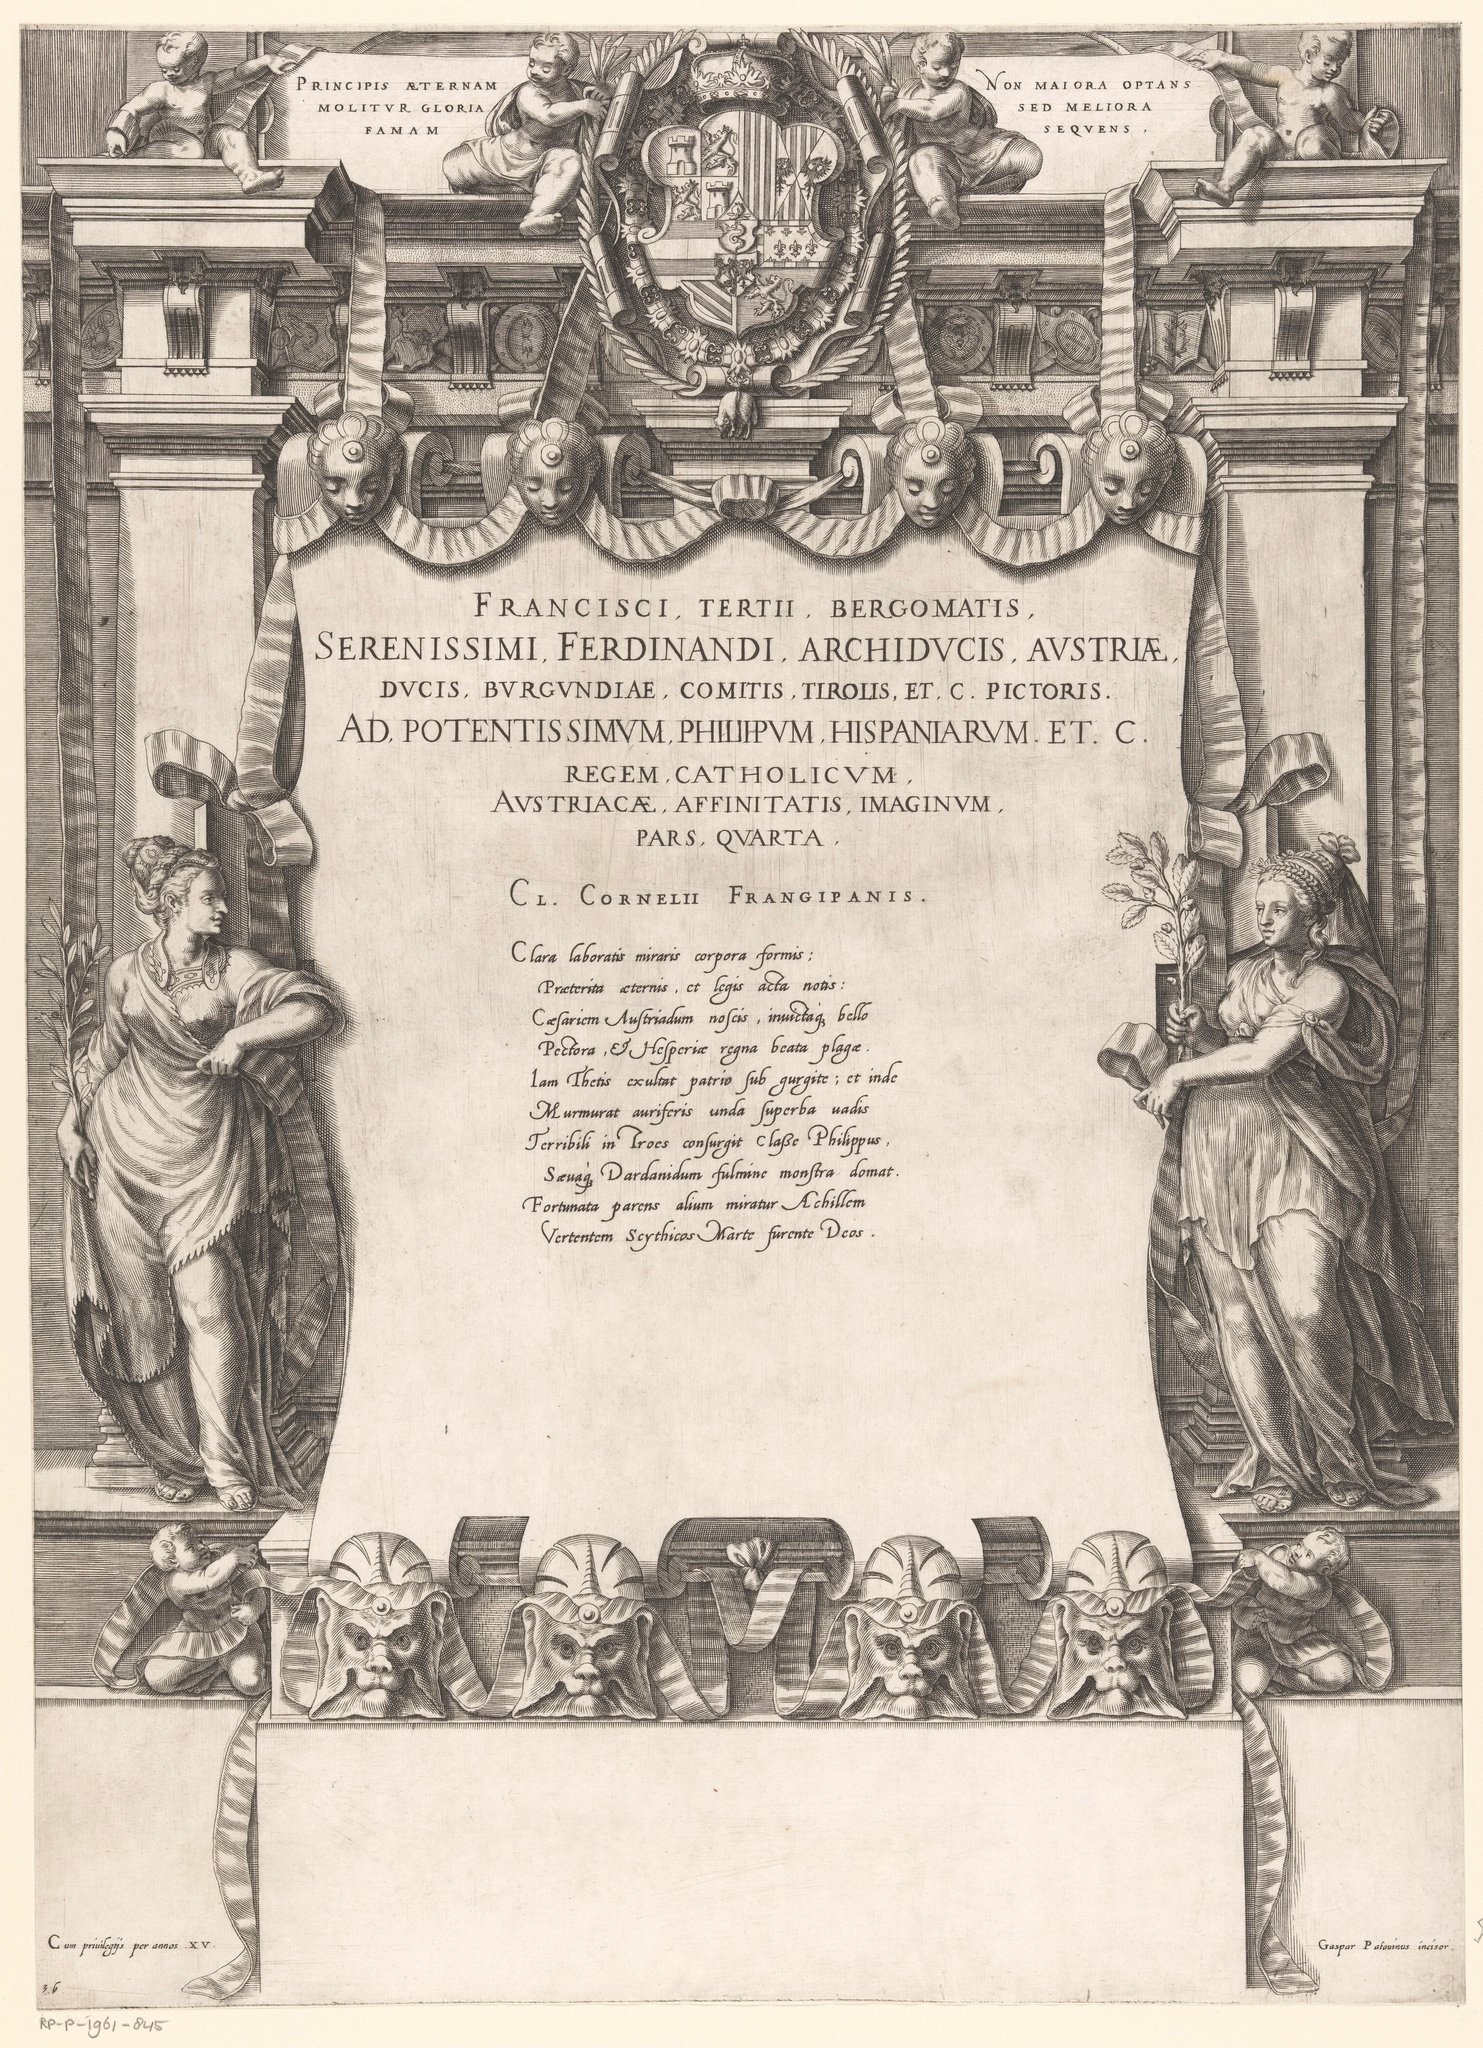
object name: print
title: Austriacae gentis imaginum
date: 1569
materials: paper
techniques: engraving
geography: italy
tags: coat of arms (symbol of sovereignty), ornaments ~ art, cupids: 'amores', 'amoretti', 'putti'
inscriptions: collector's mark: Lugt 2228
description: Deze prent maakt deel uit van een reeks van 58 prenten. Het meerendeel van de prenten bevat portretten van 74 leden van het Oostenrijkse Huis, naar tekeningen door Francesco Terzio, die deels getekend zijn naar de 28 levensgrote bronzen beelden die rond de cenotaaf van Maximiliaan I in de Hofkirche te Innsbruck staan.